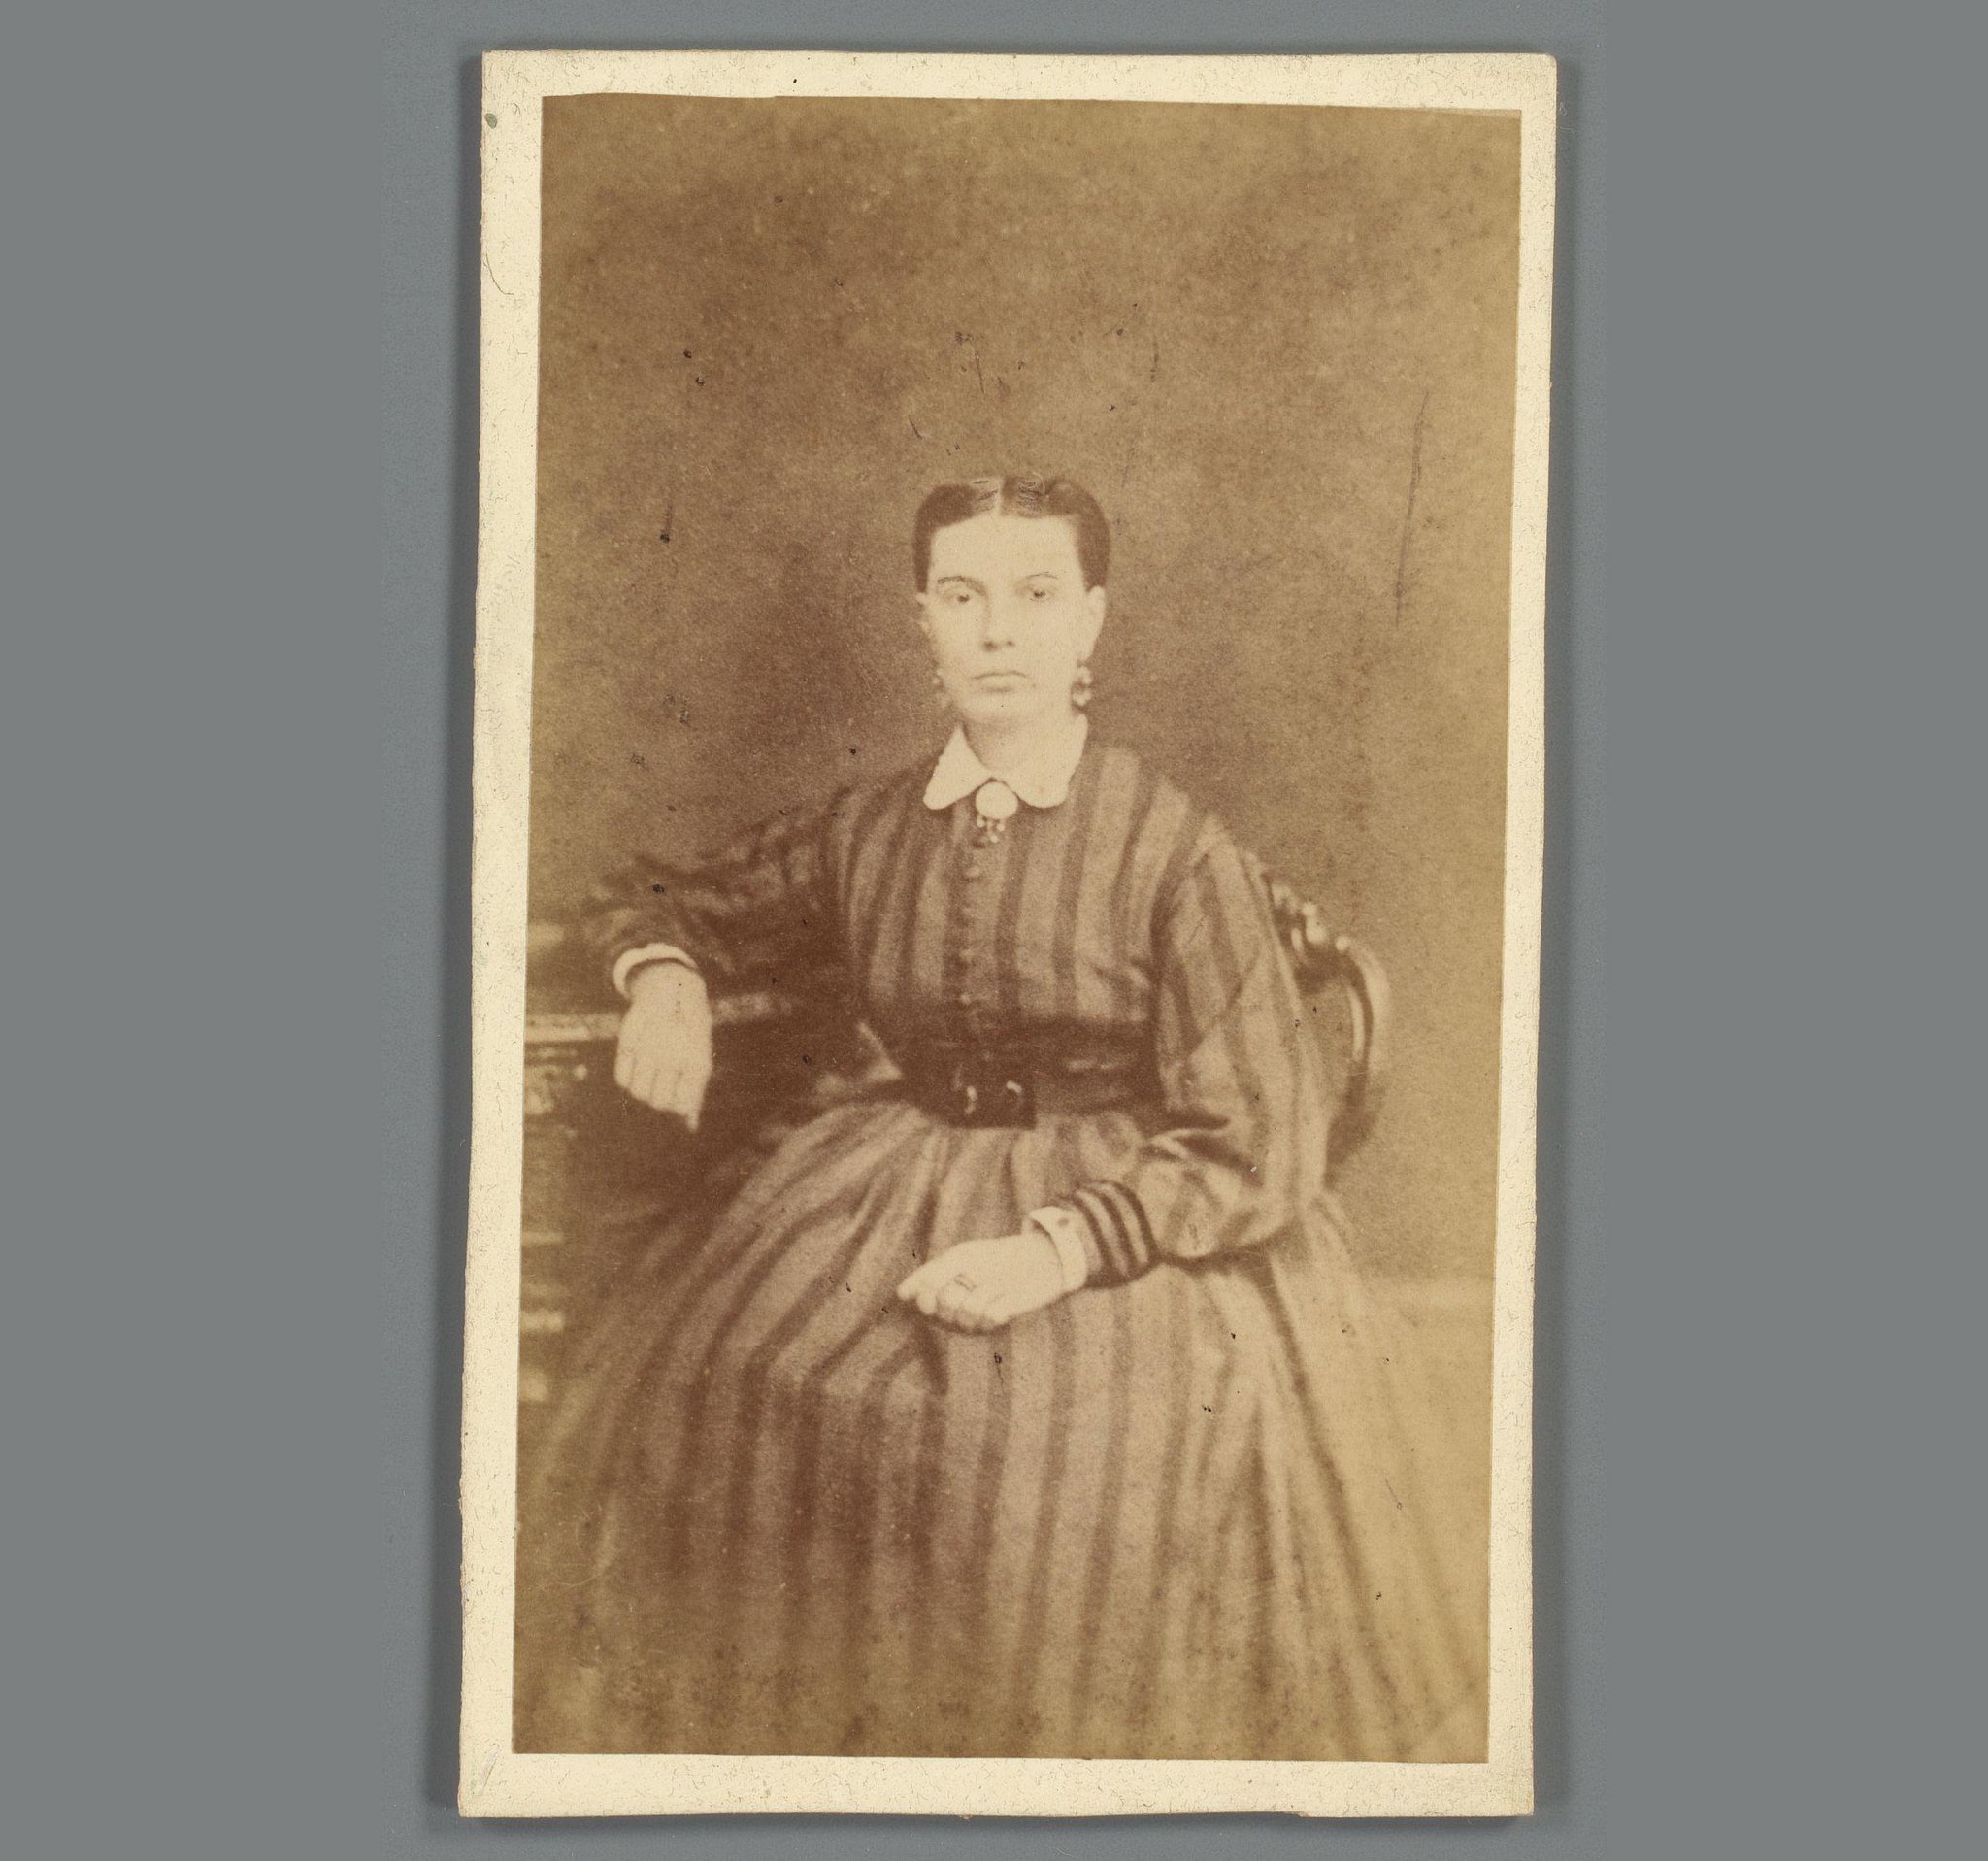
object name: photograph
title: Portret van een onbekende vrouw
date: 1892-1902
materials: cardboard, paper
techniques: albumen print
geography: antwerp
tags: adult woman, anonymous historical person portrayed, antwerp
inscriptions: inscription: ‘Photographie du "Fiat Lux"./ Médaille d'or/ à l'Exposition d'Anvers./ F. Piron & Co./ Rue Léopold 55./ Anvers./ Spécialité de portraits au Platine/ et au charbon/ Les clichés sont conservés’